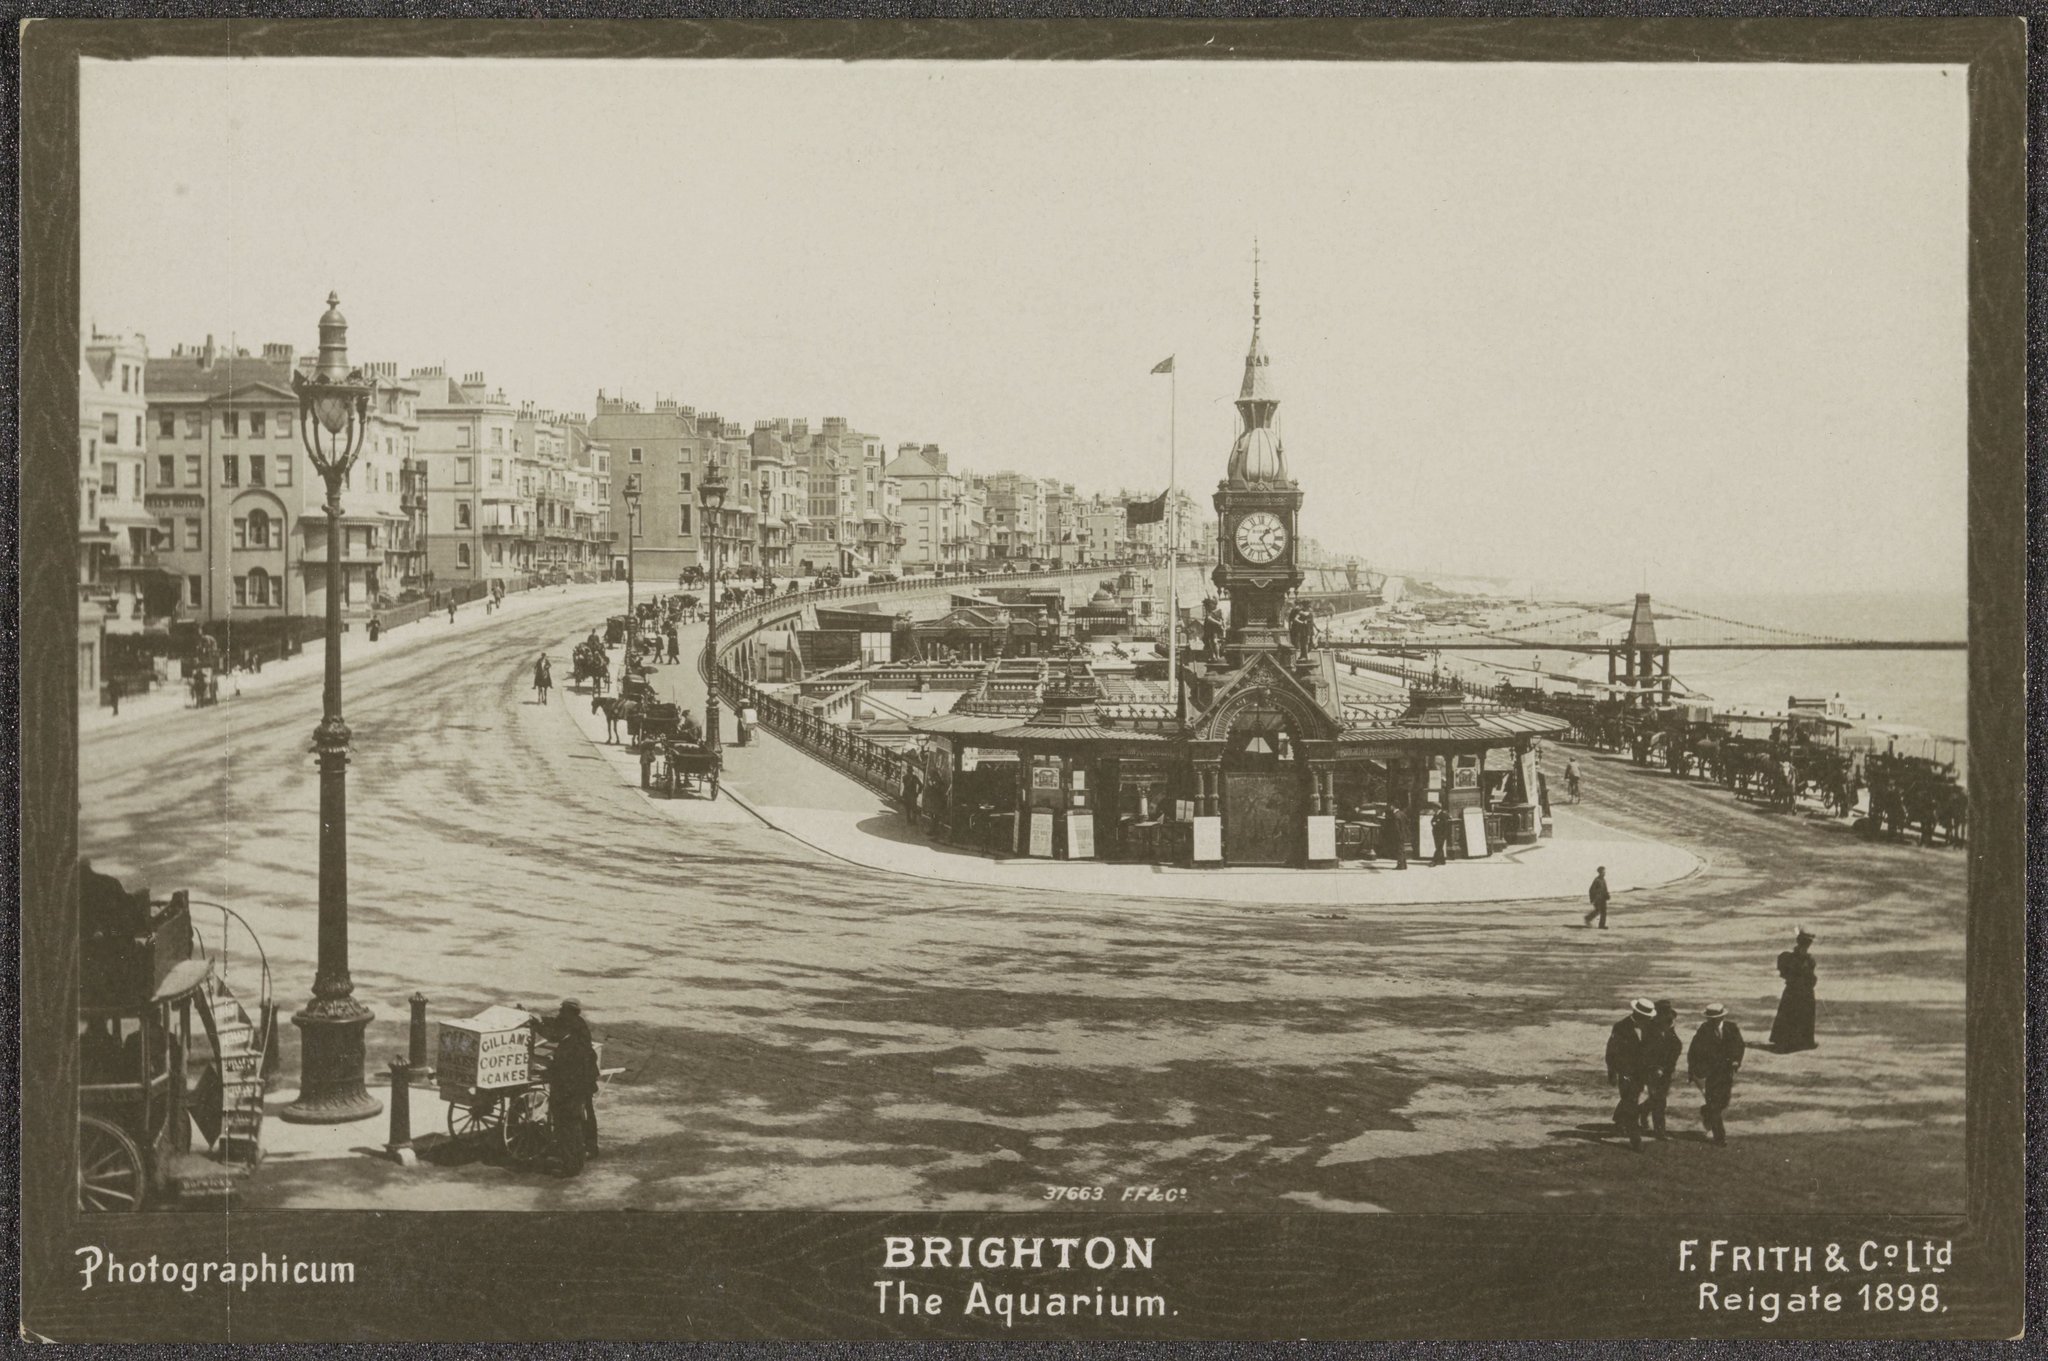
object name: photograph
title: Brighton The Aquarium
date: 1870-1898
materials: photographic support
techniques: gelatin silver print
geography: brighton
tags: four-wheeled, animal-drawn vehicle, e.g.: cab, carriage, coach (+ conveyance for transport of persons), tower, clock tower ~ monumental adornment, avenue, boulevard, promenade, esplanade (+ city(-scape) with figures, staffage), travelling; tourism, zoo (as place of recreation)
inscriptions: inscription: ‘Reigate 1898’, inscription: ‘Photographicum’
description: Foto hoort bij een serie van 28 losse prentbriefkaarten van Engeland, Noorwegen, Italië, Duitsland en Tirol (foto's RP-F-F00945-1 t/m RP-F-F00945-28).